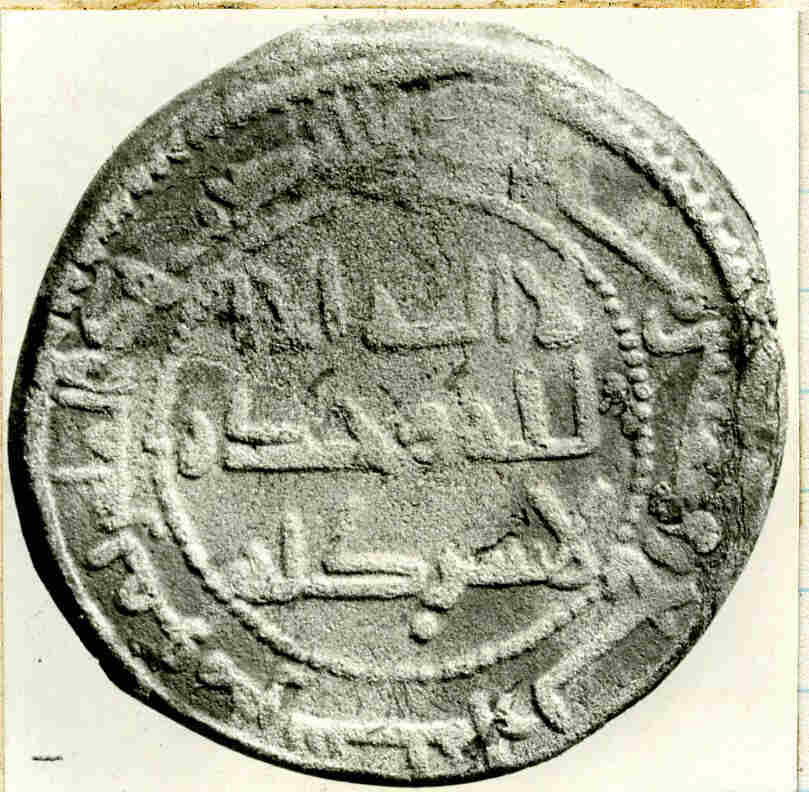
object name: coin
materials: copper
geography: qumis